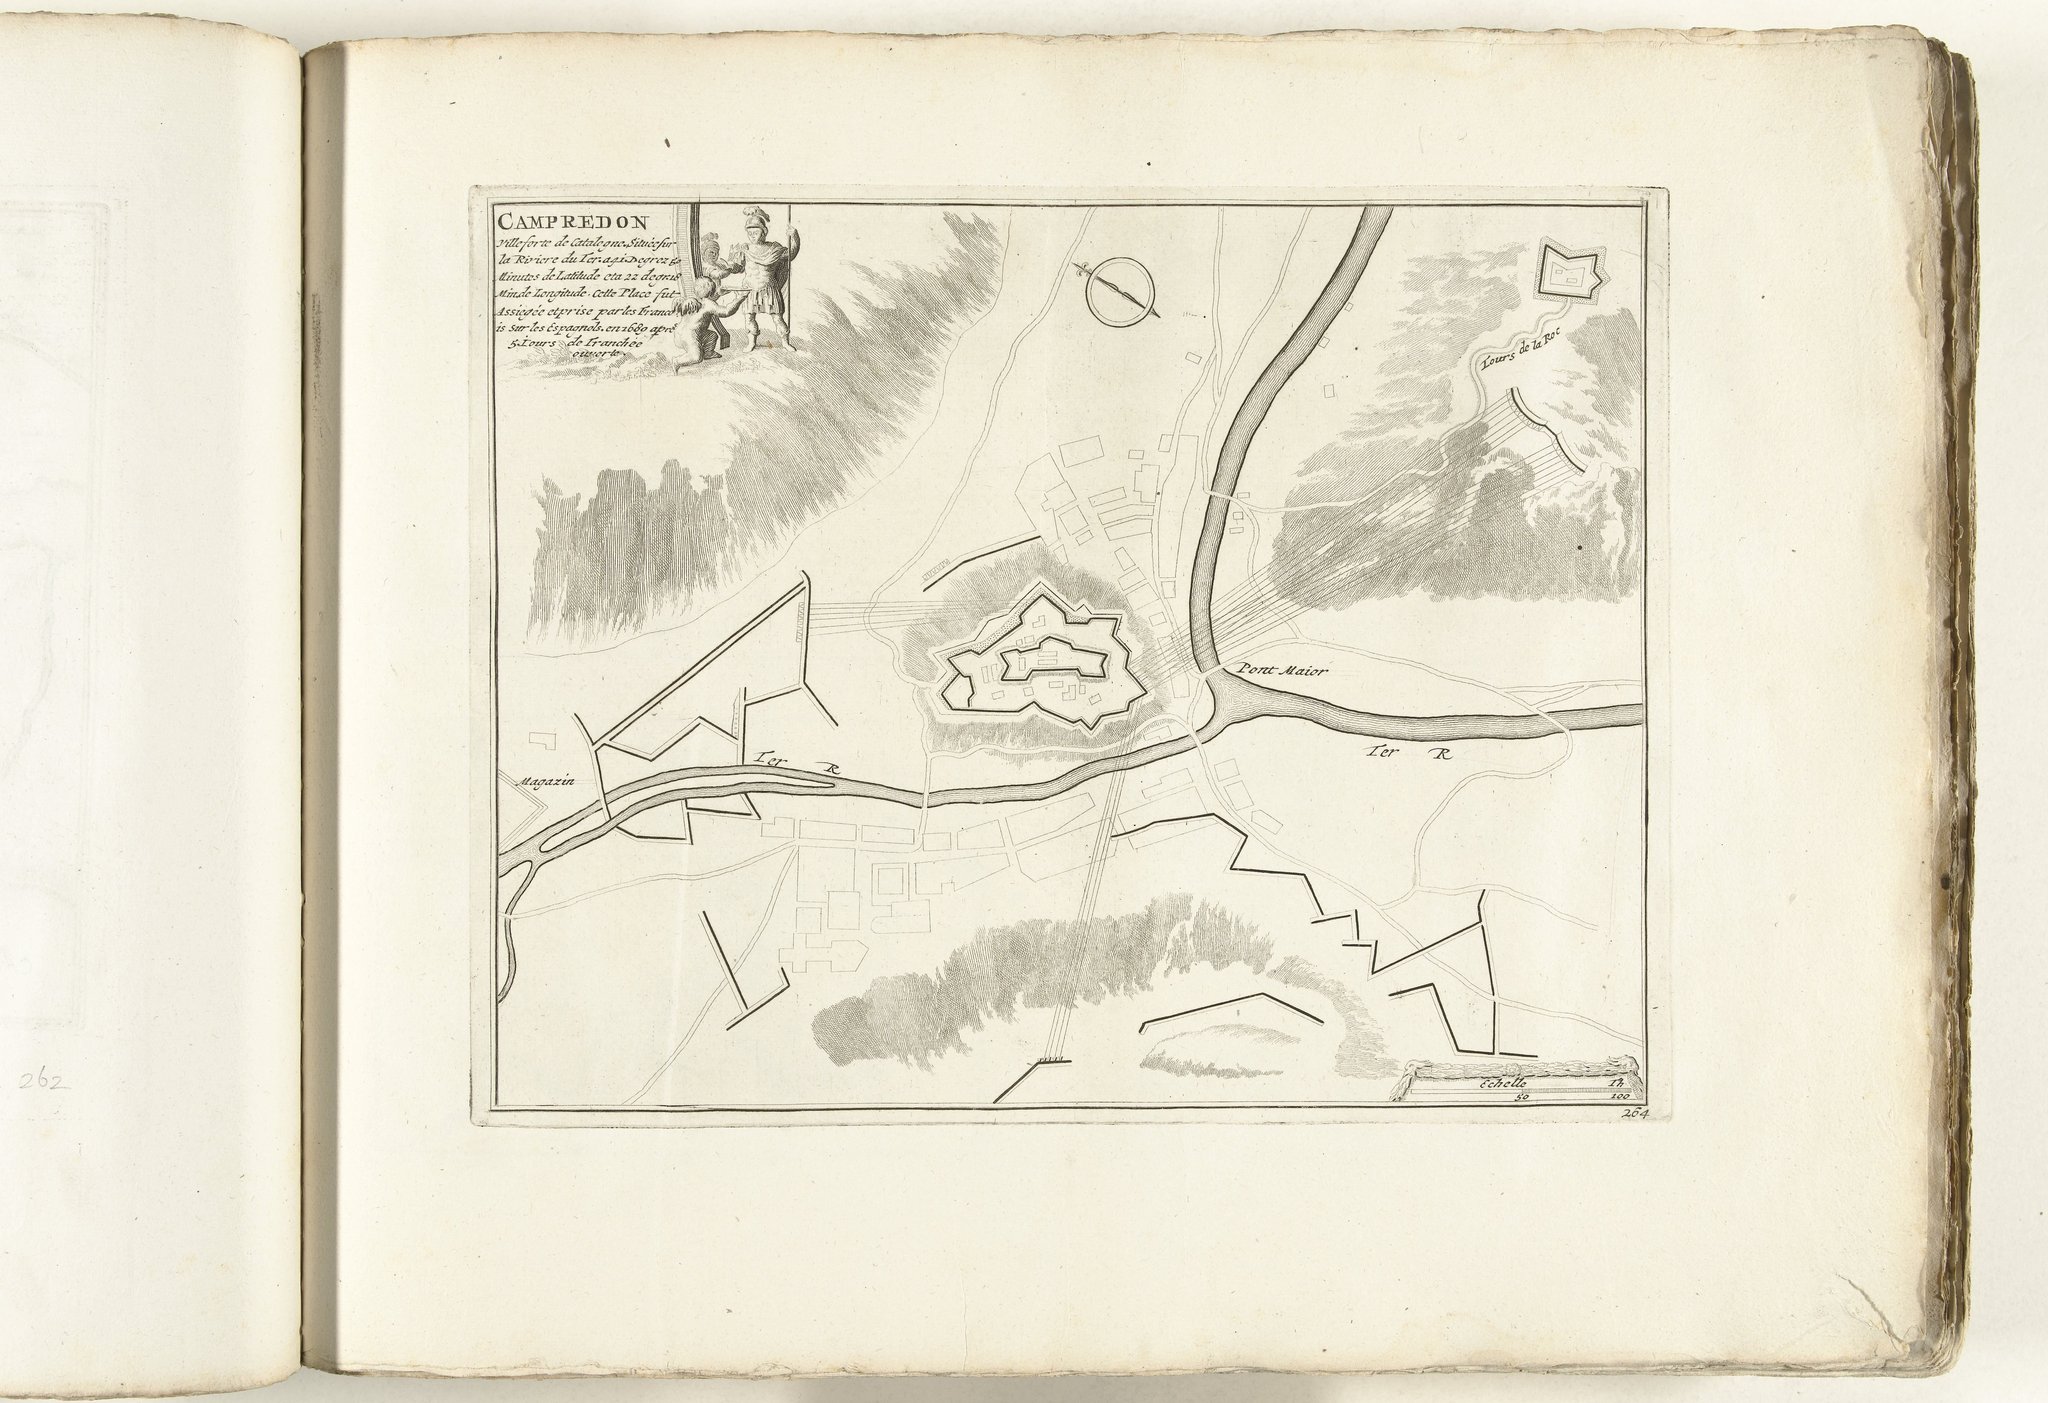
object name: print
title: Campredon Ville forte de Catalogne (...) Assiegée et prise par les Francois sur les Espagnols, en 1689 (...)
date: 1702-1703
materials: paper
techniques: etching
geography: amsterdam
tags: siege, position war, maps of cities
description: Beleg van het Spaanse fort Campredon in Calatonië aan de rivier Ter door het Franse leger, veroverd in 1689. Plaat nr. 264 in het prentwerk bestaande in totaal uit 276 genummerde platen van vermaarde sterke steden en vestingen in het kader van de Spaanse Successieoorlog. Voor het merendeel zijn deze platen gekopieerd naar de anonieme Franse platen: in Les forces de l'Europe en in: Le theatre de la guerre, dans les Pays-Bas, beide oorspronkelijk uitgegeven door Nicolas de Fer te Parijs (1693-1697) in het kader van de Negenjarige Oorlog. Titel en opschriften in de plaat in het Frans.